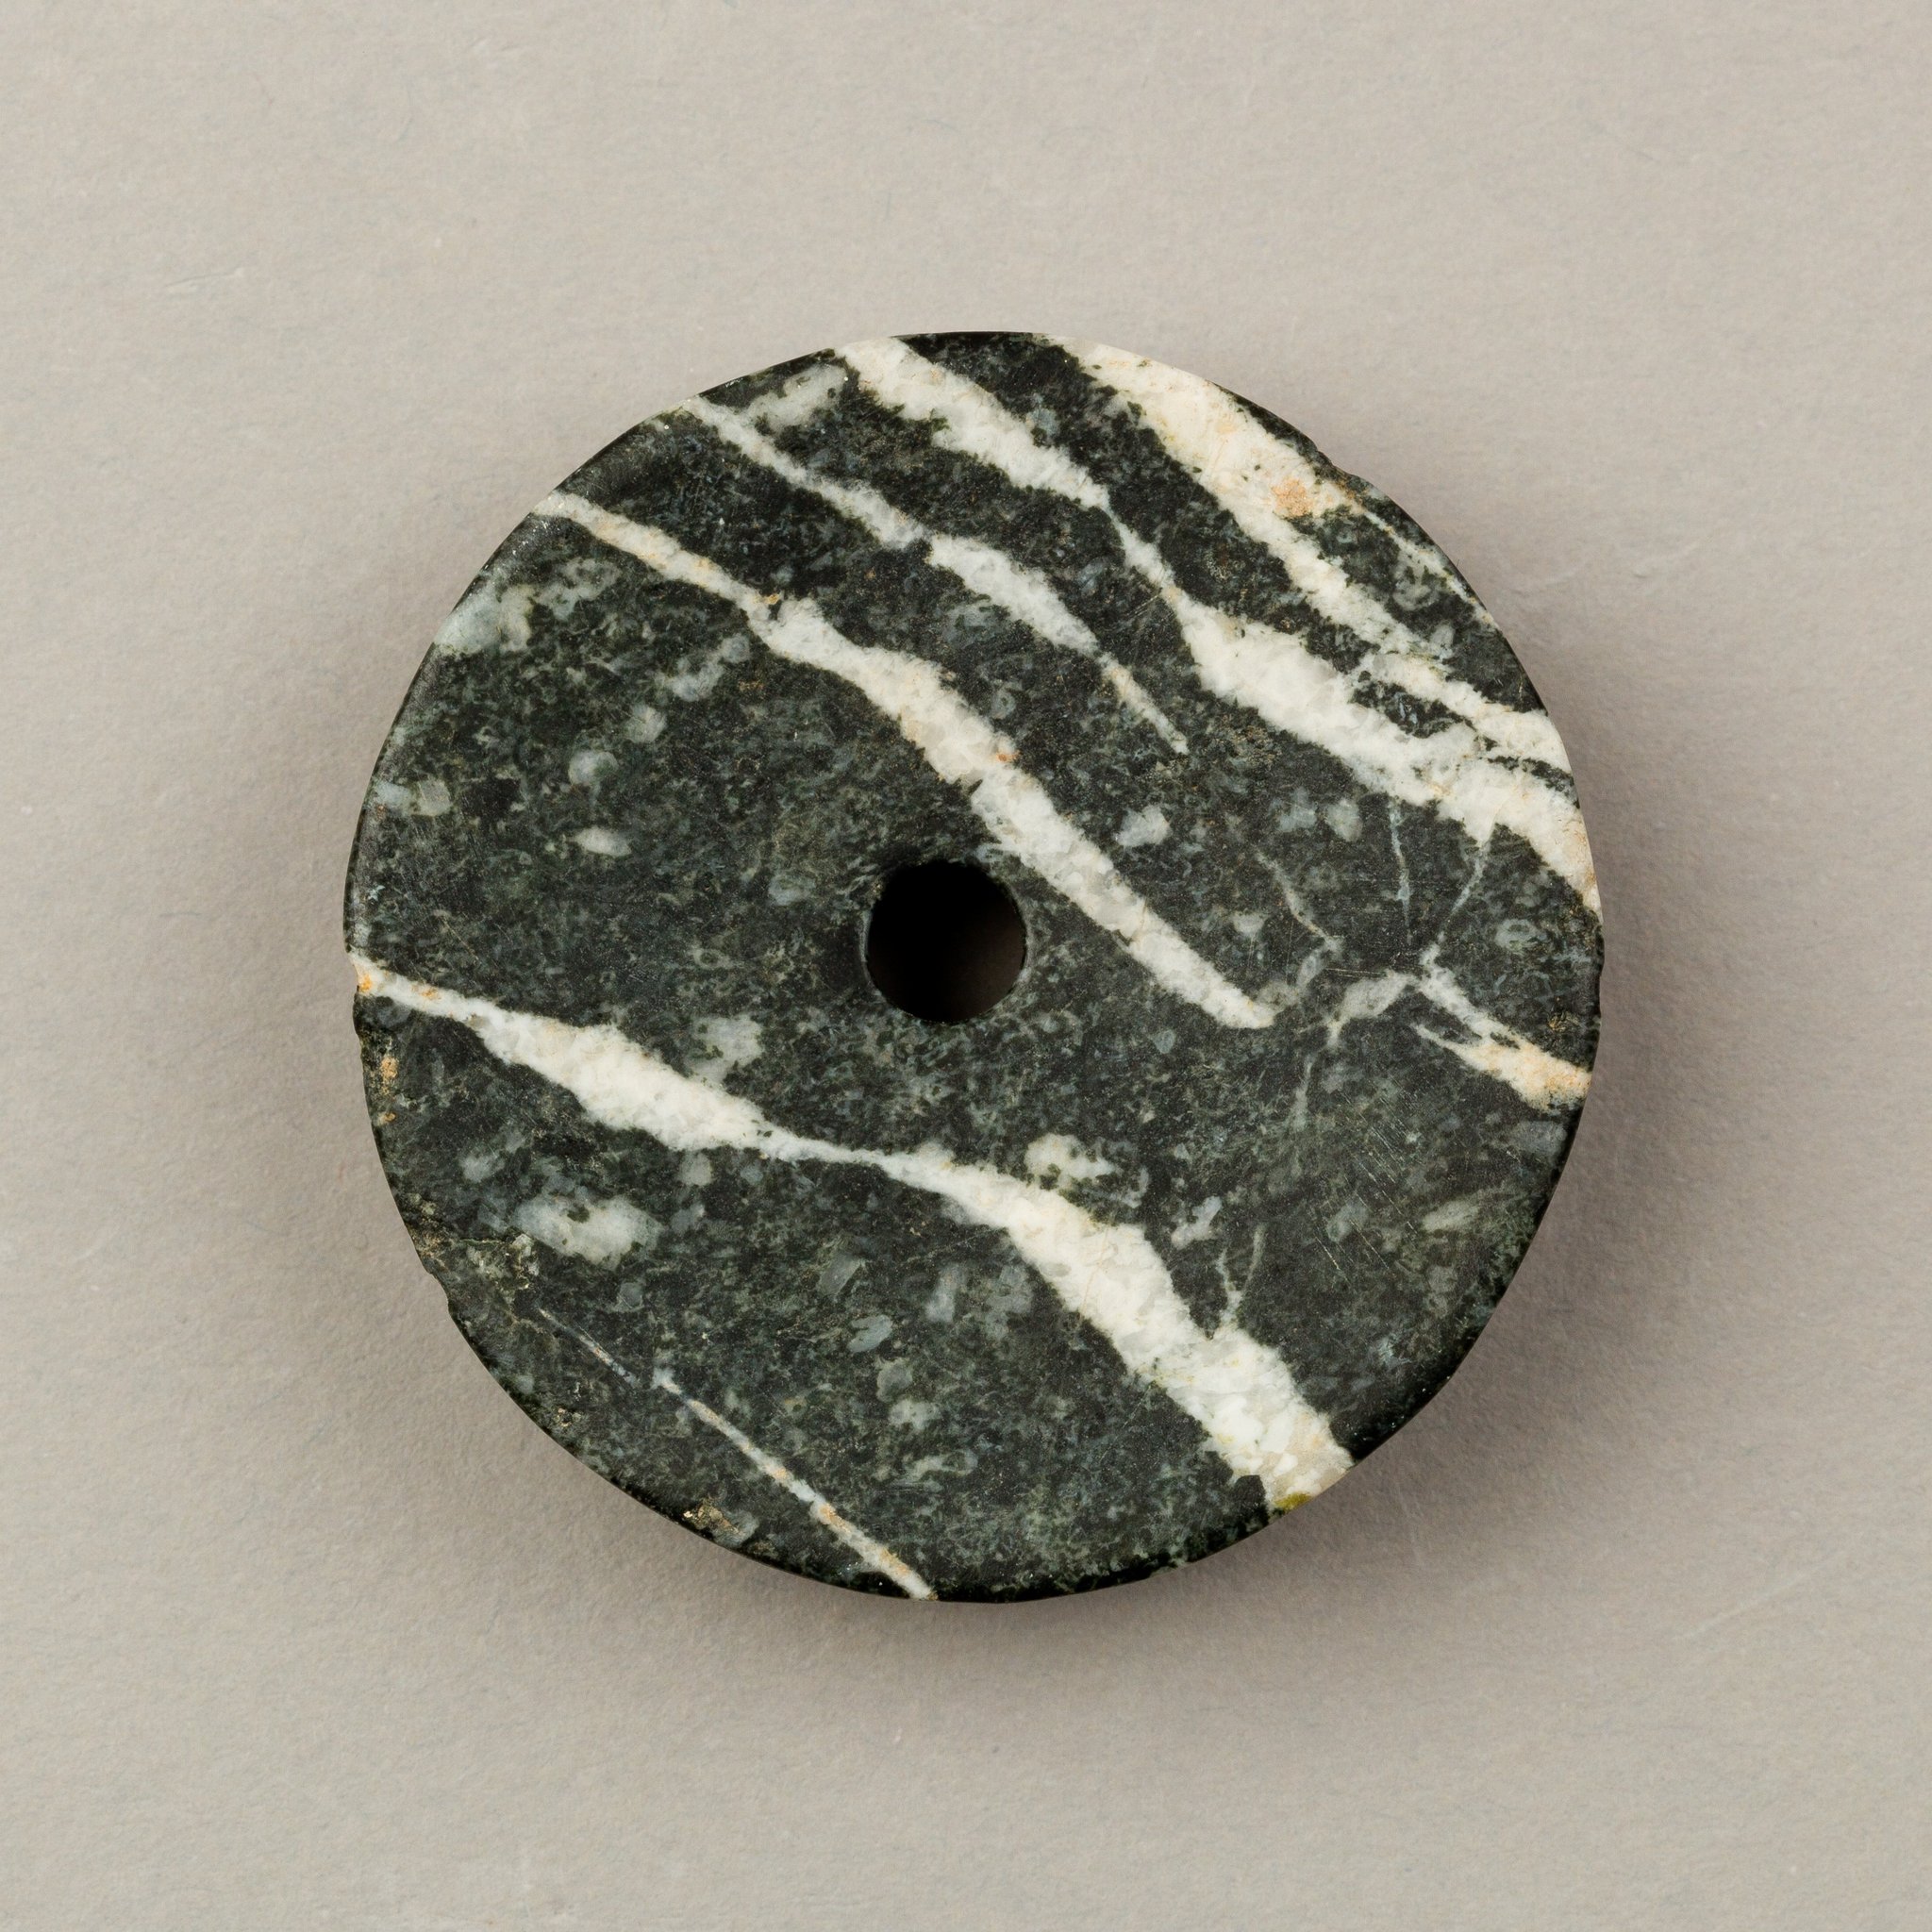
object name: mace head, disc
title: Disc-shaped mace head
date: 3850-2960 BCE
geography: egypt